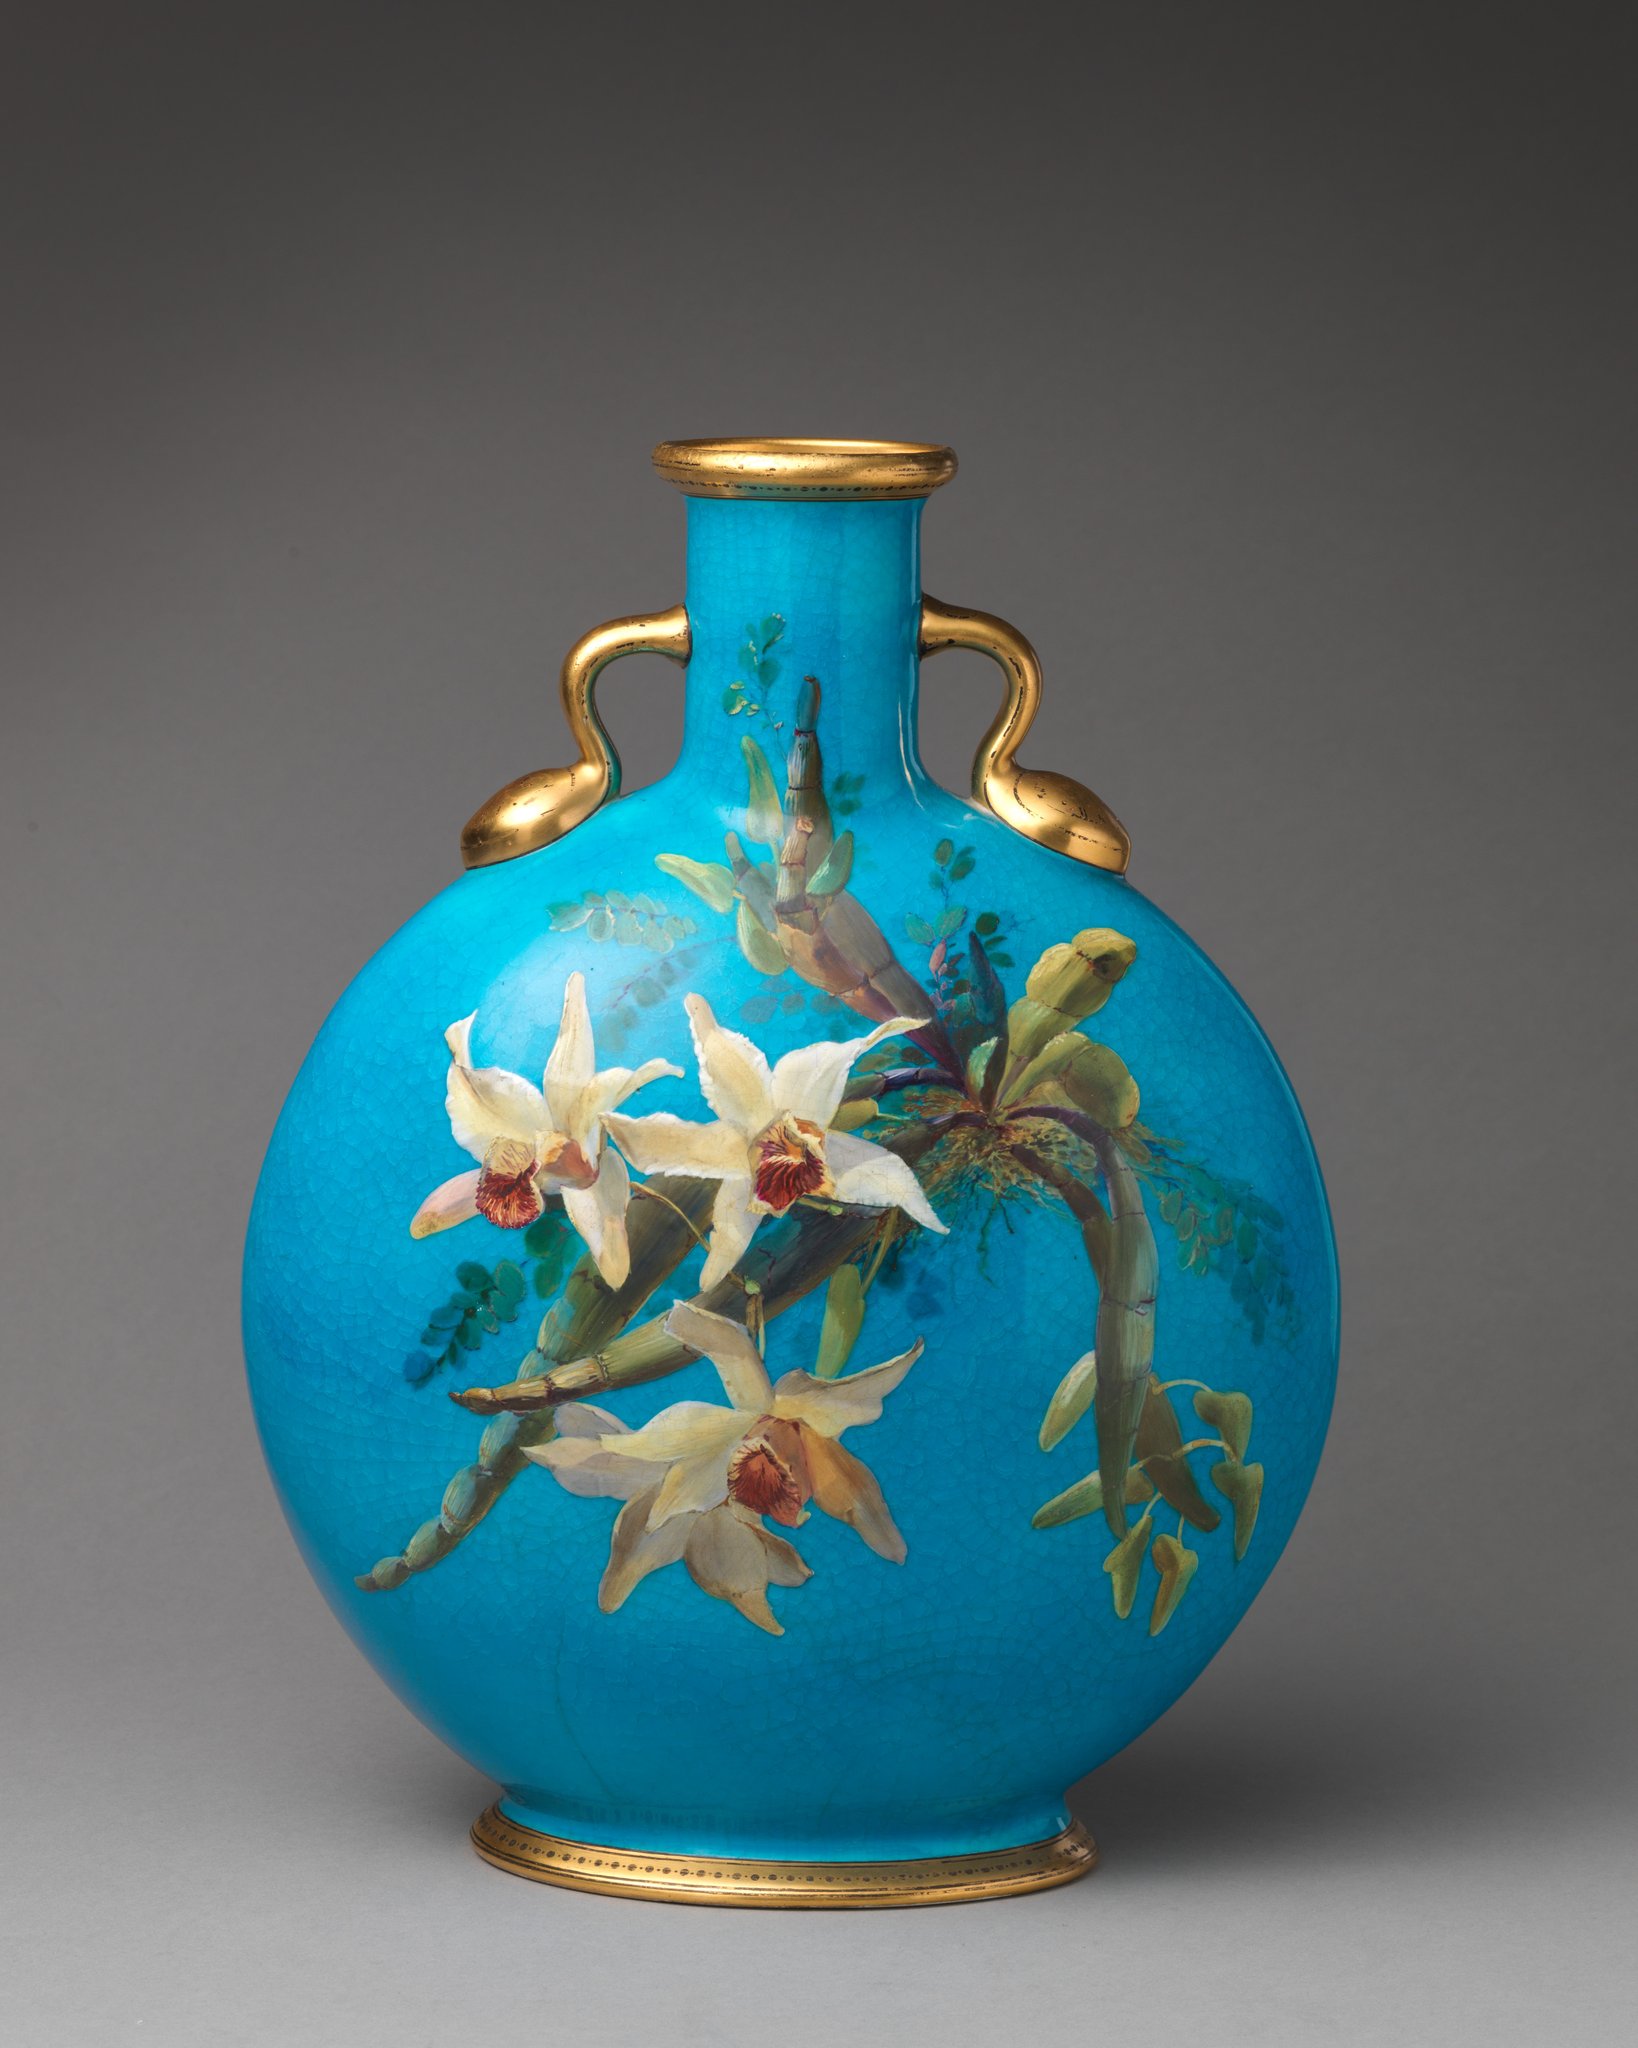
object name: moon flask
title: Moon flask with orchids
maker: minton(s)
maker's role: maker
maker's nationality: british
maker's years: 1793-2001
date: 1872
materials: bone china